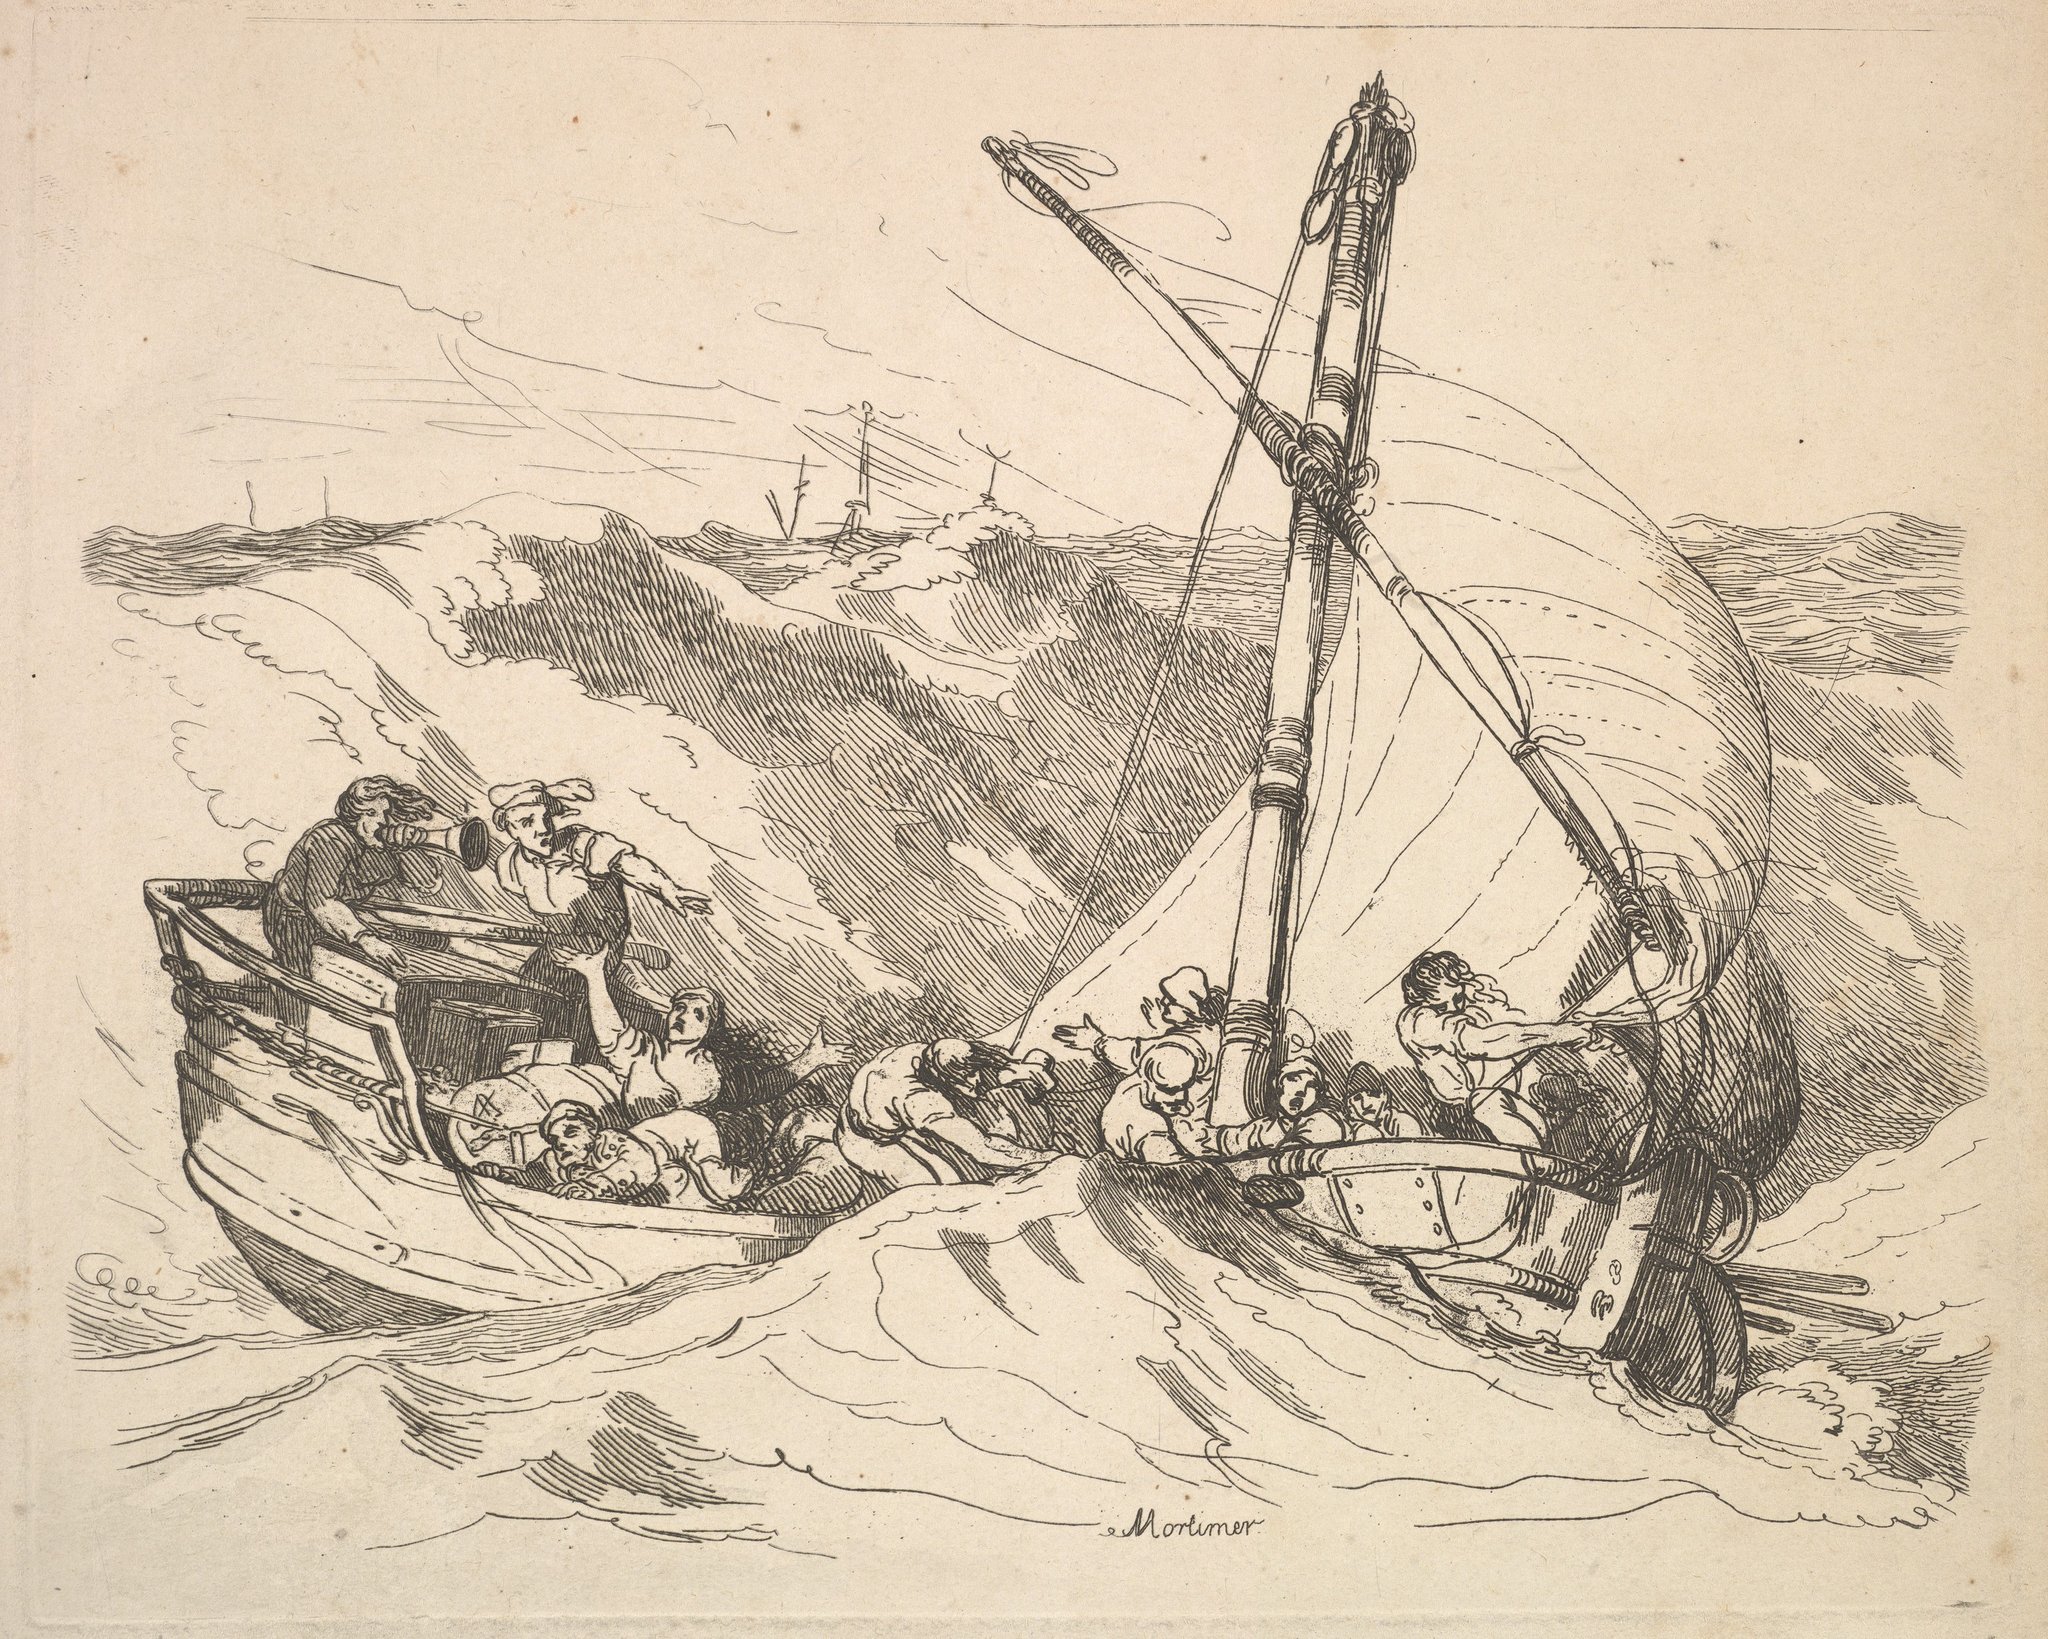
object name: print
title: Boat in a Storm at Sea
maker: thomas rowlandson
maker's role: artist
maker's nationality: british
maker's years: 1757-1827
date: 1784-1788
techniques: etching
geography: england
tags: waves,storms,boats